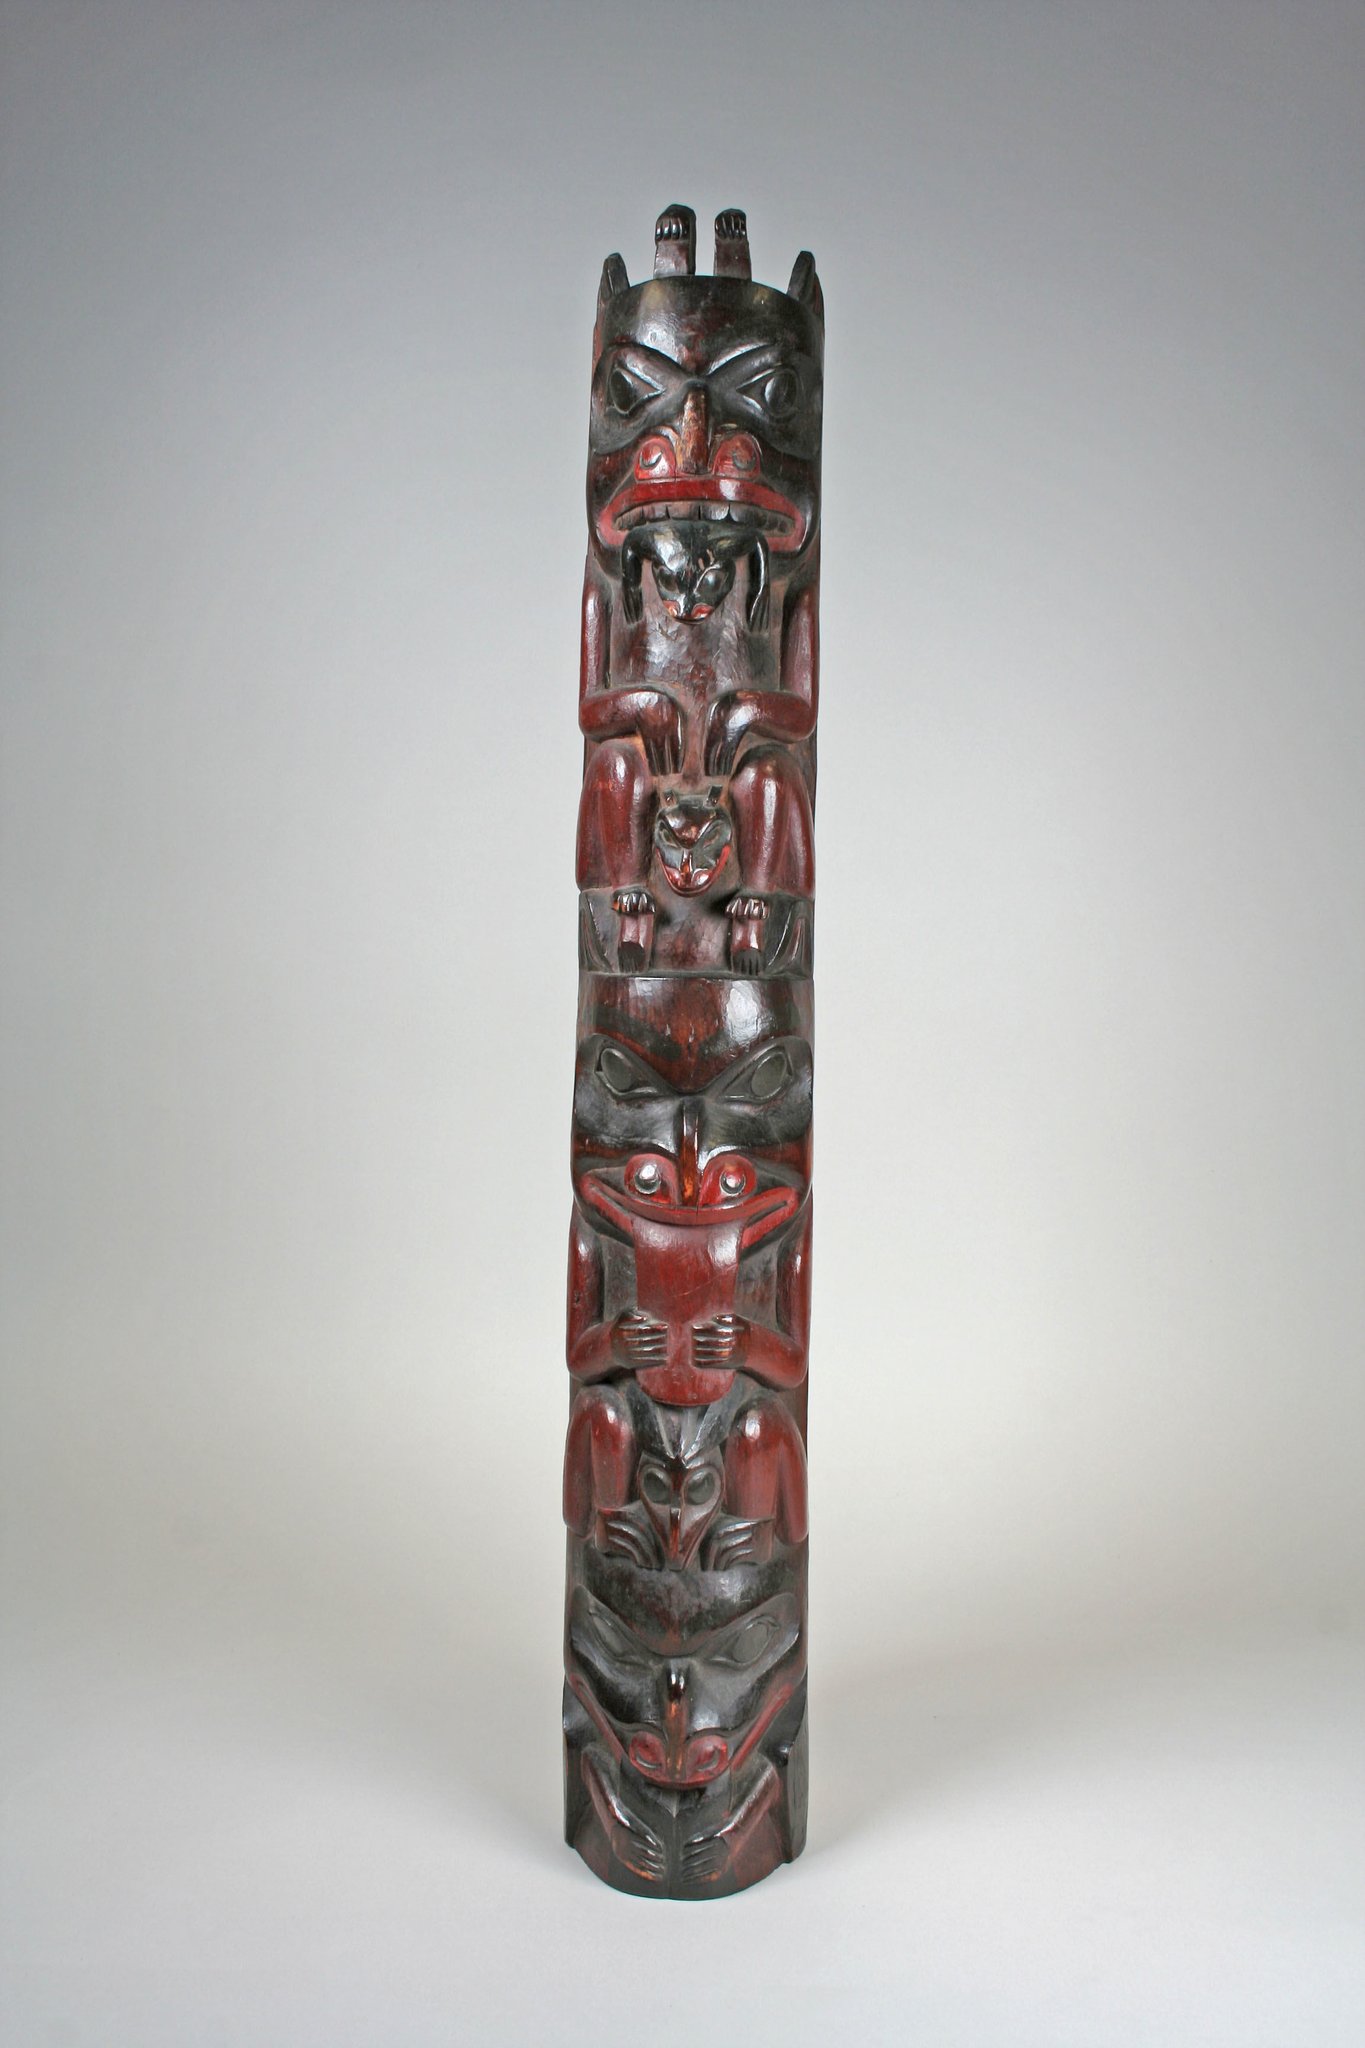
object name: totem pole model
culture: haida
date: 1875-1885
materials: pigment, wood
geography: canada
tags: animals